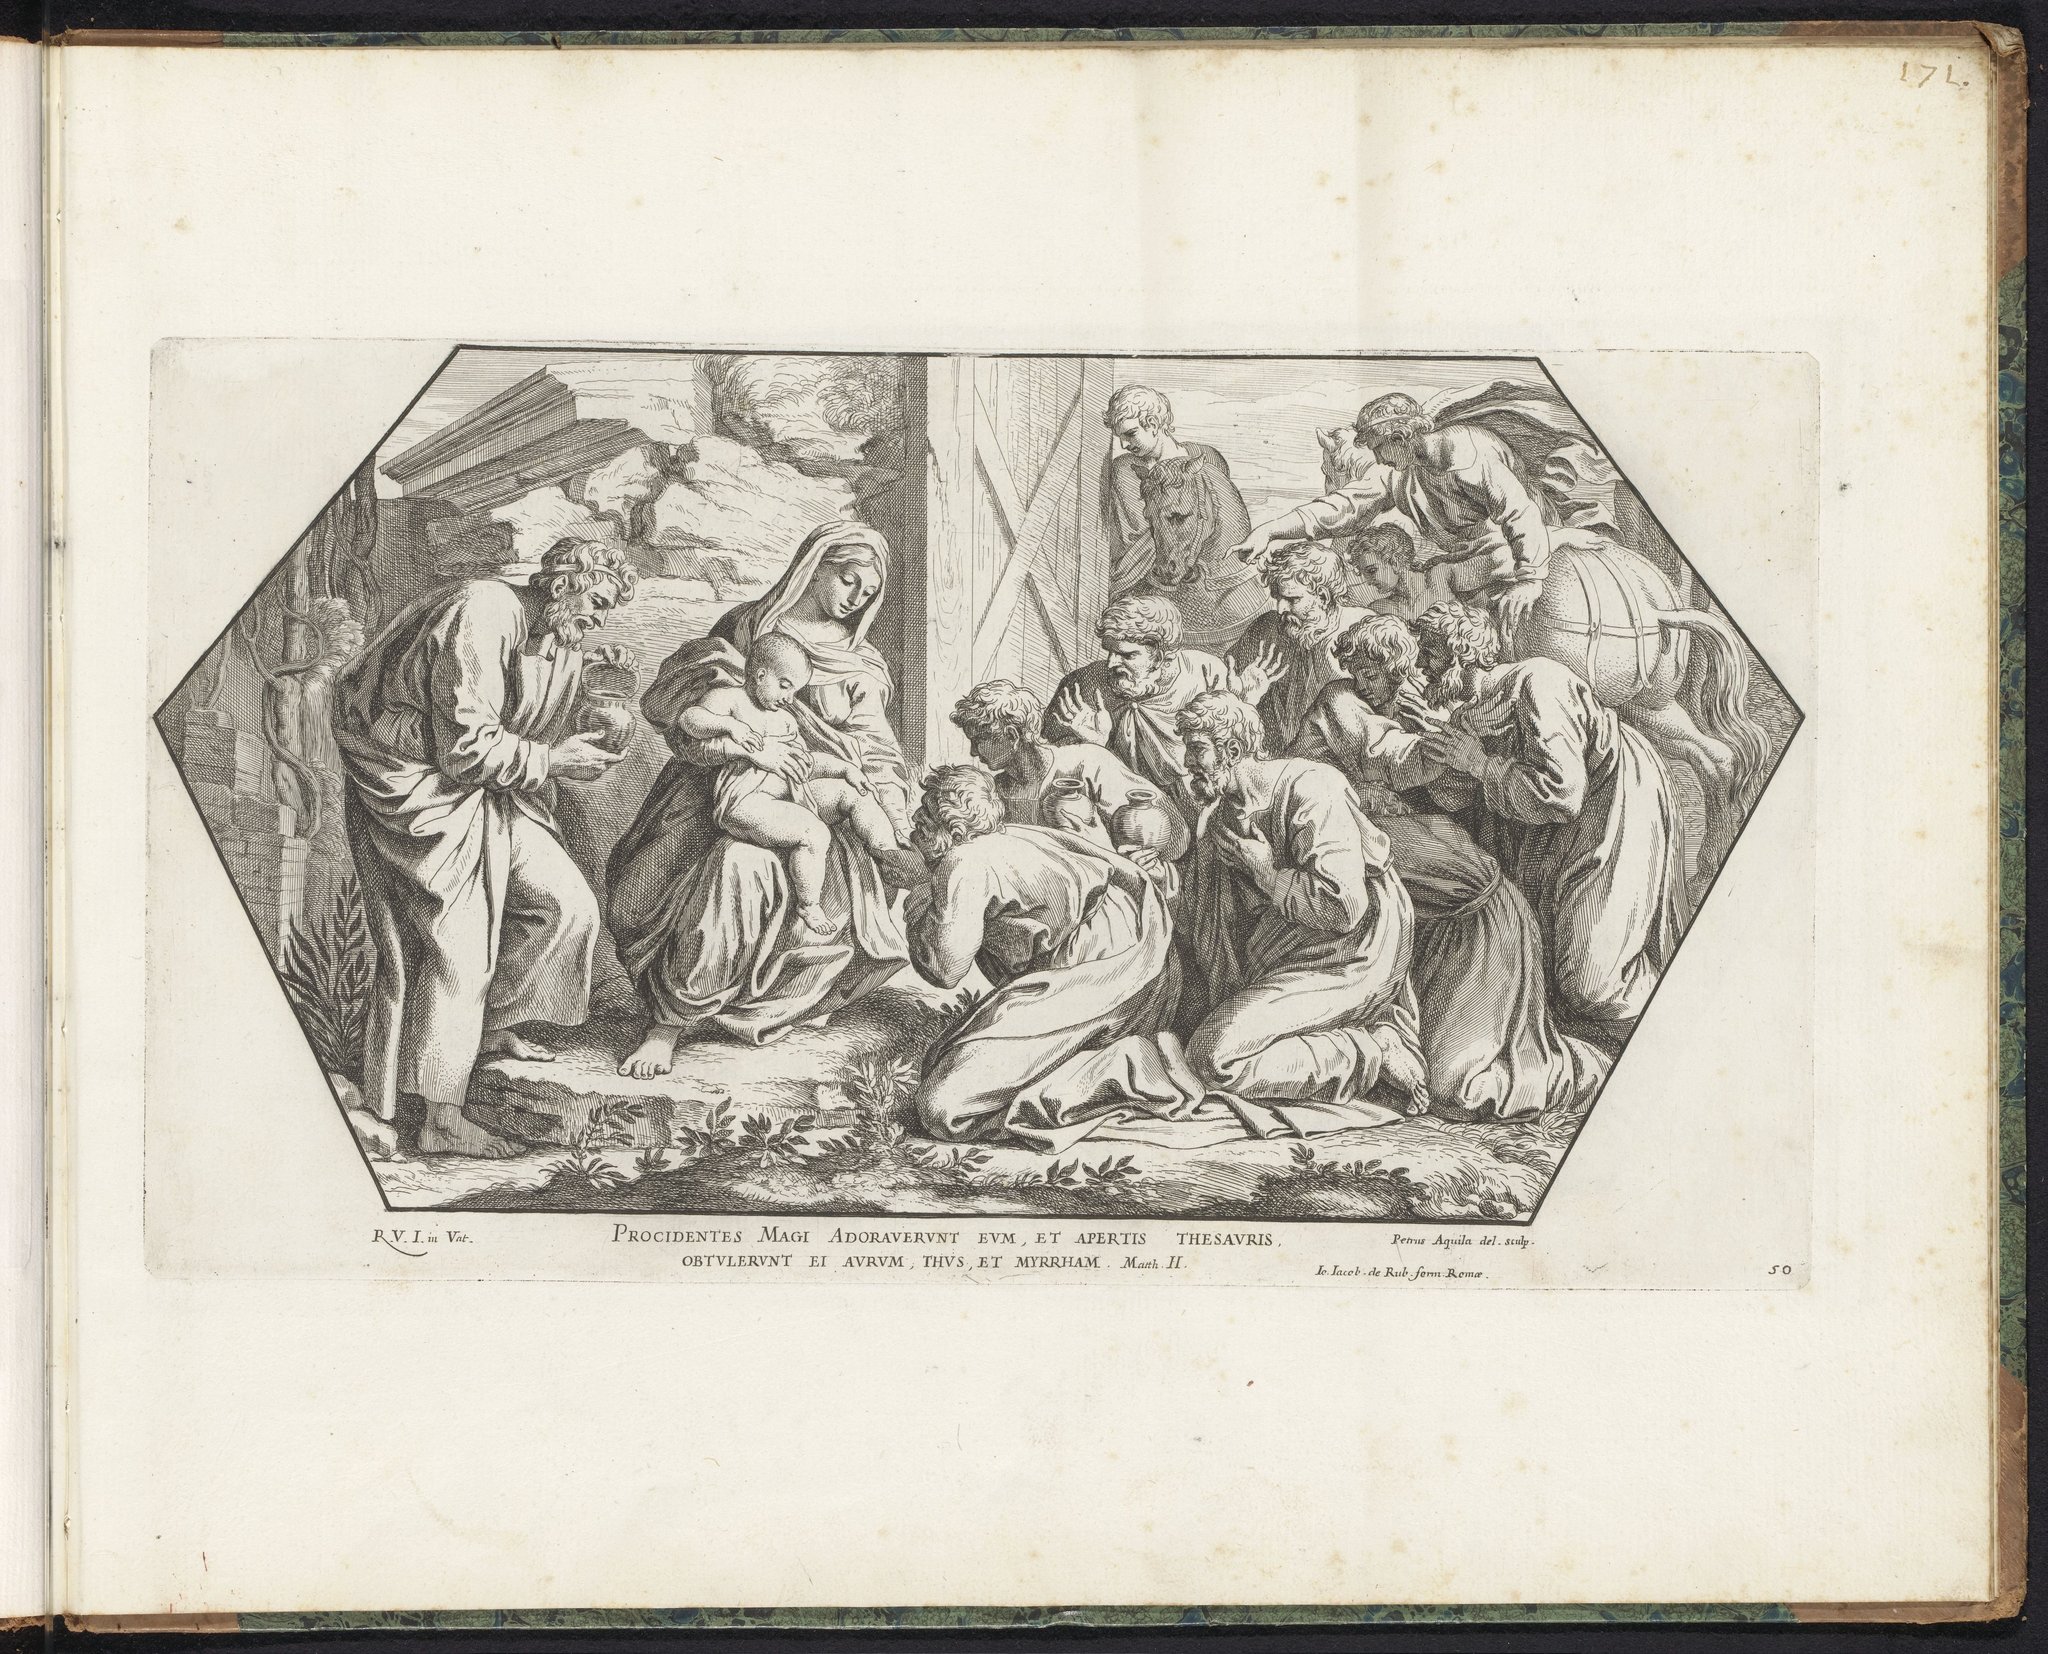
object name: album leaf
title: Schilderingen in de Loggia van Rafaël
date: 1675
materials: paper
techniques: etching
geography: italy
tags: adoration of the kings: the wise men present their gifts to the christ-child (gold, frankincense and myrrh)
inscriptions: number: ‘171’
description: Voor een stal aanbidden de drie koningen, Maria en Jozef het Christuskind. De koningen bieden geschenken aan. Bijbelvers onder de voorstelling. Prent maakt deel uit van een album.